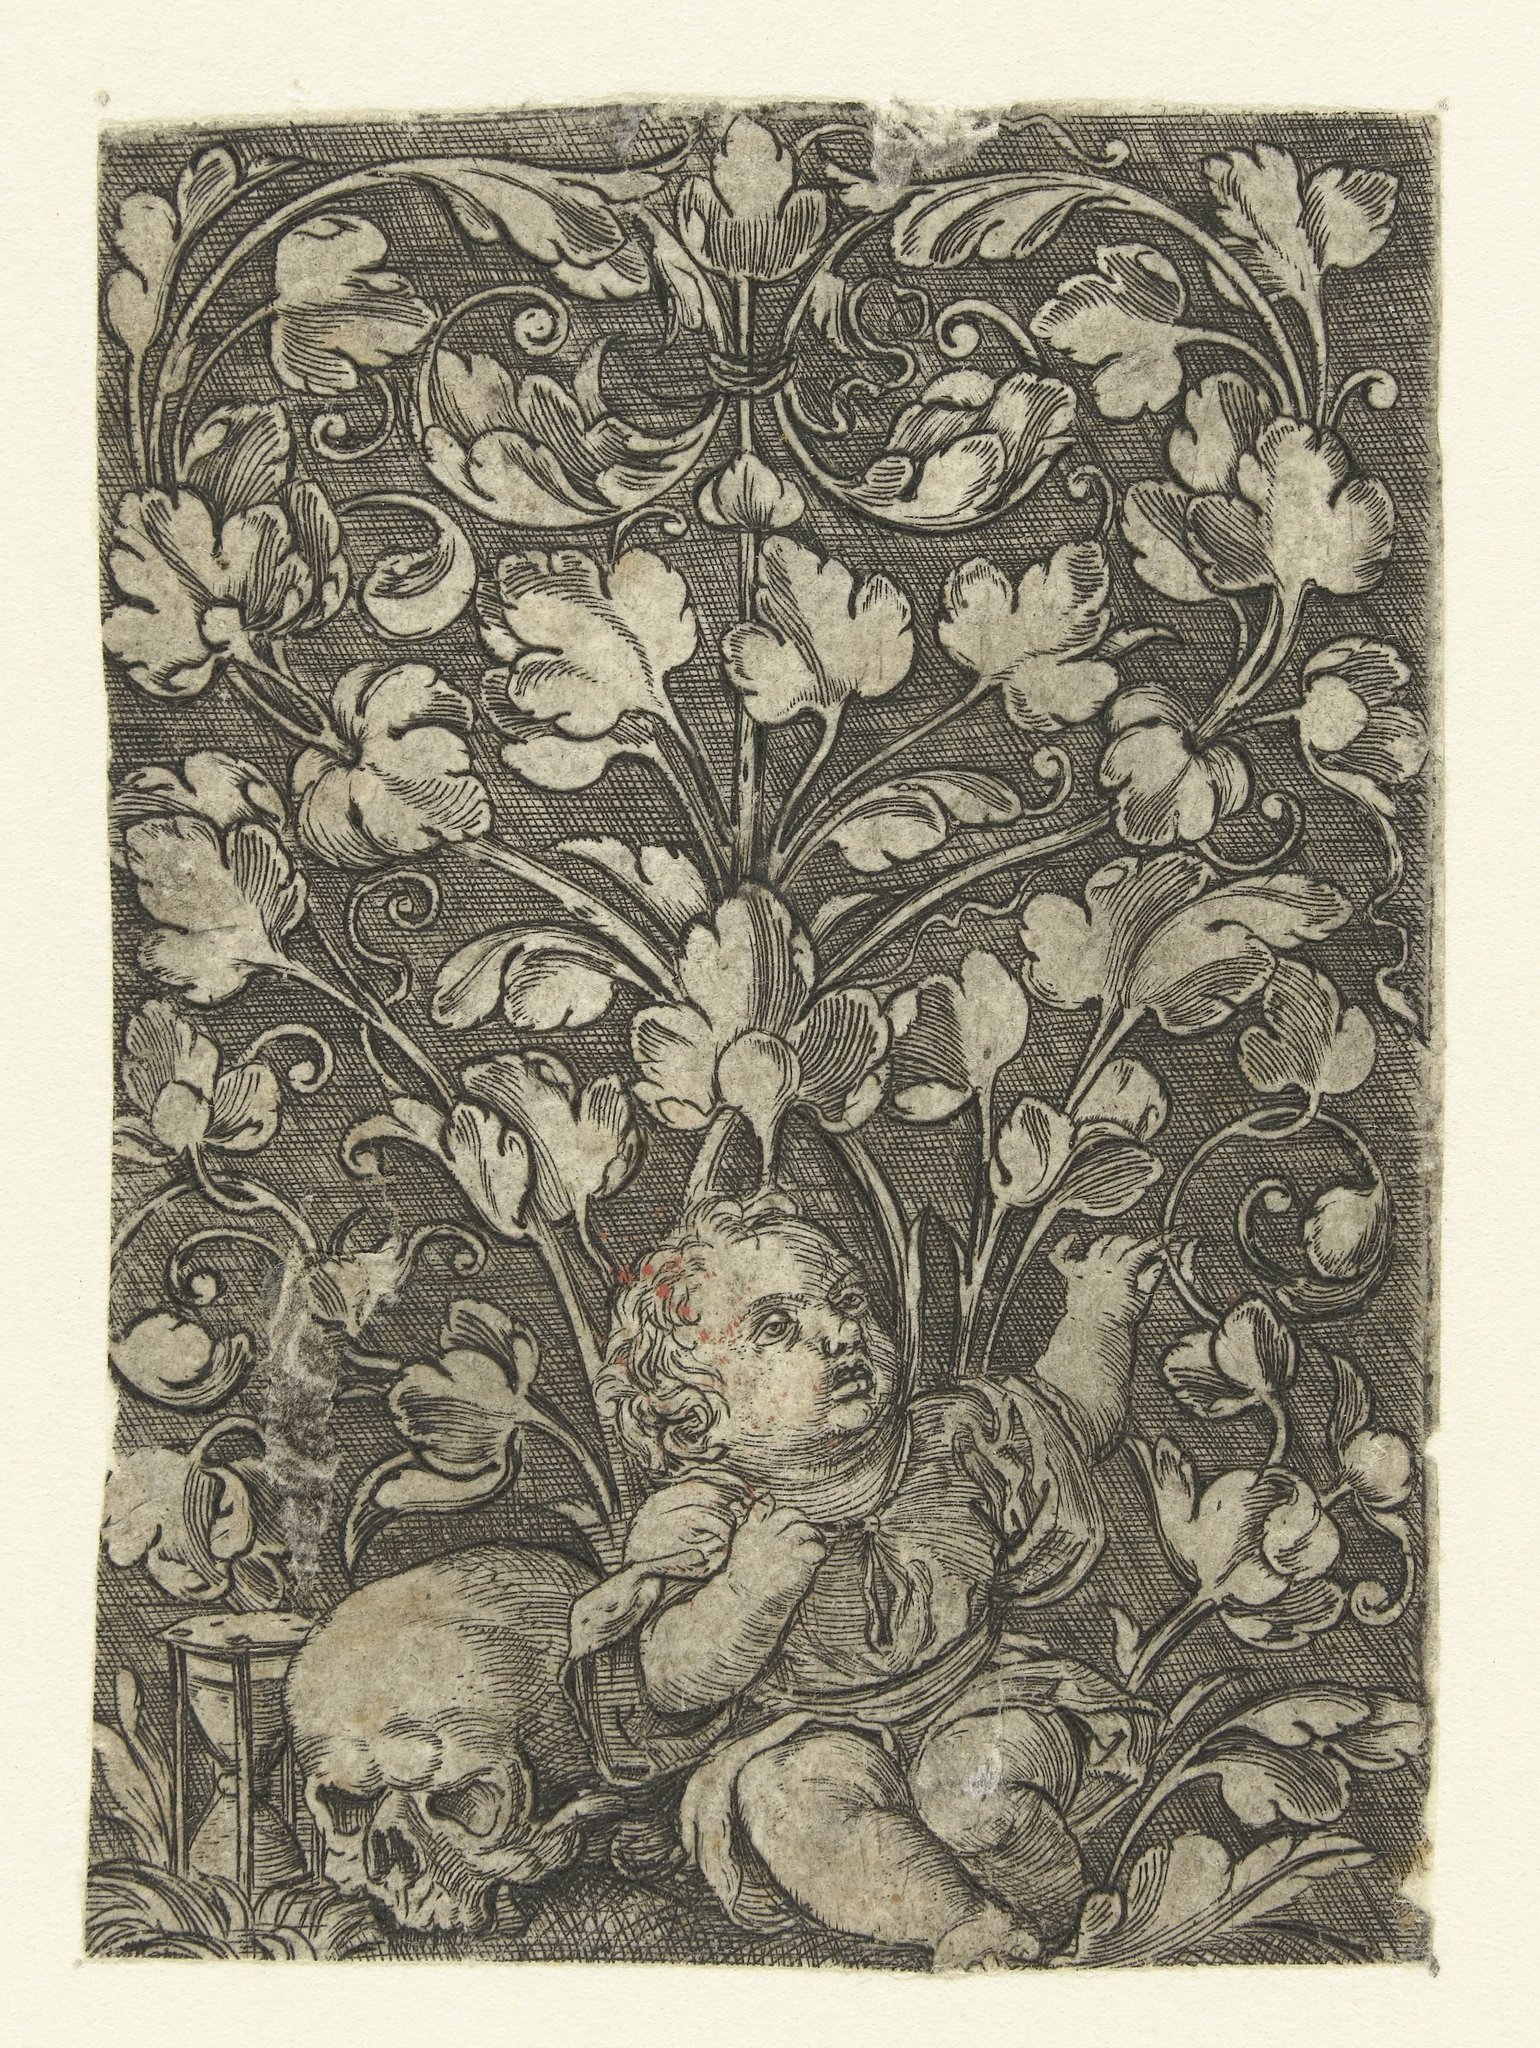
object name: ornament print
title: Vlakdecoraties met bladranken en kinderen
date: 1500-1600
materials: paper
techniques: engraving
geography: germany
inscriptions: collector's mark: Lugt 240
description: Vlakdecoratie met onderaan een kind dat naast een doodshoofd en een zandloper zit. Gearceerde achtergrond. Eén van 4 bladen.